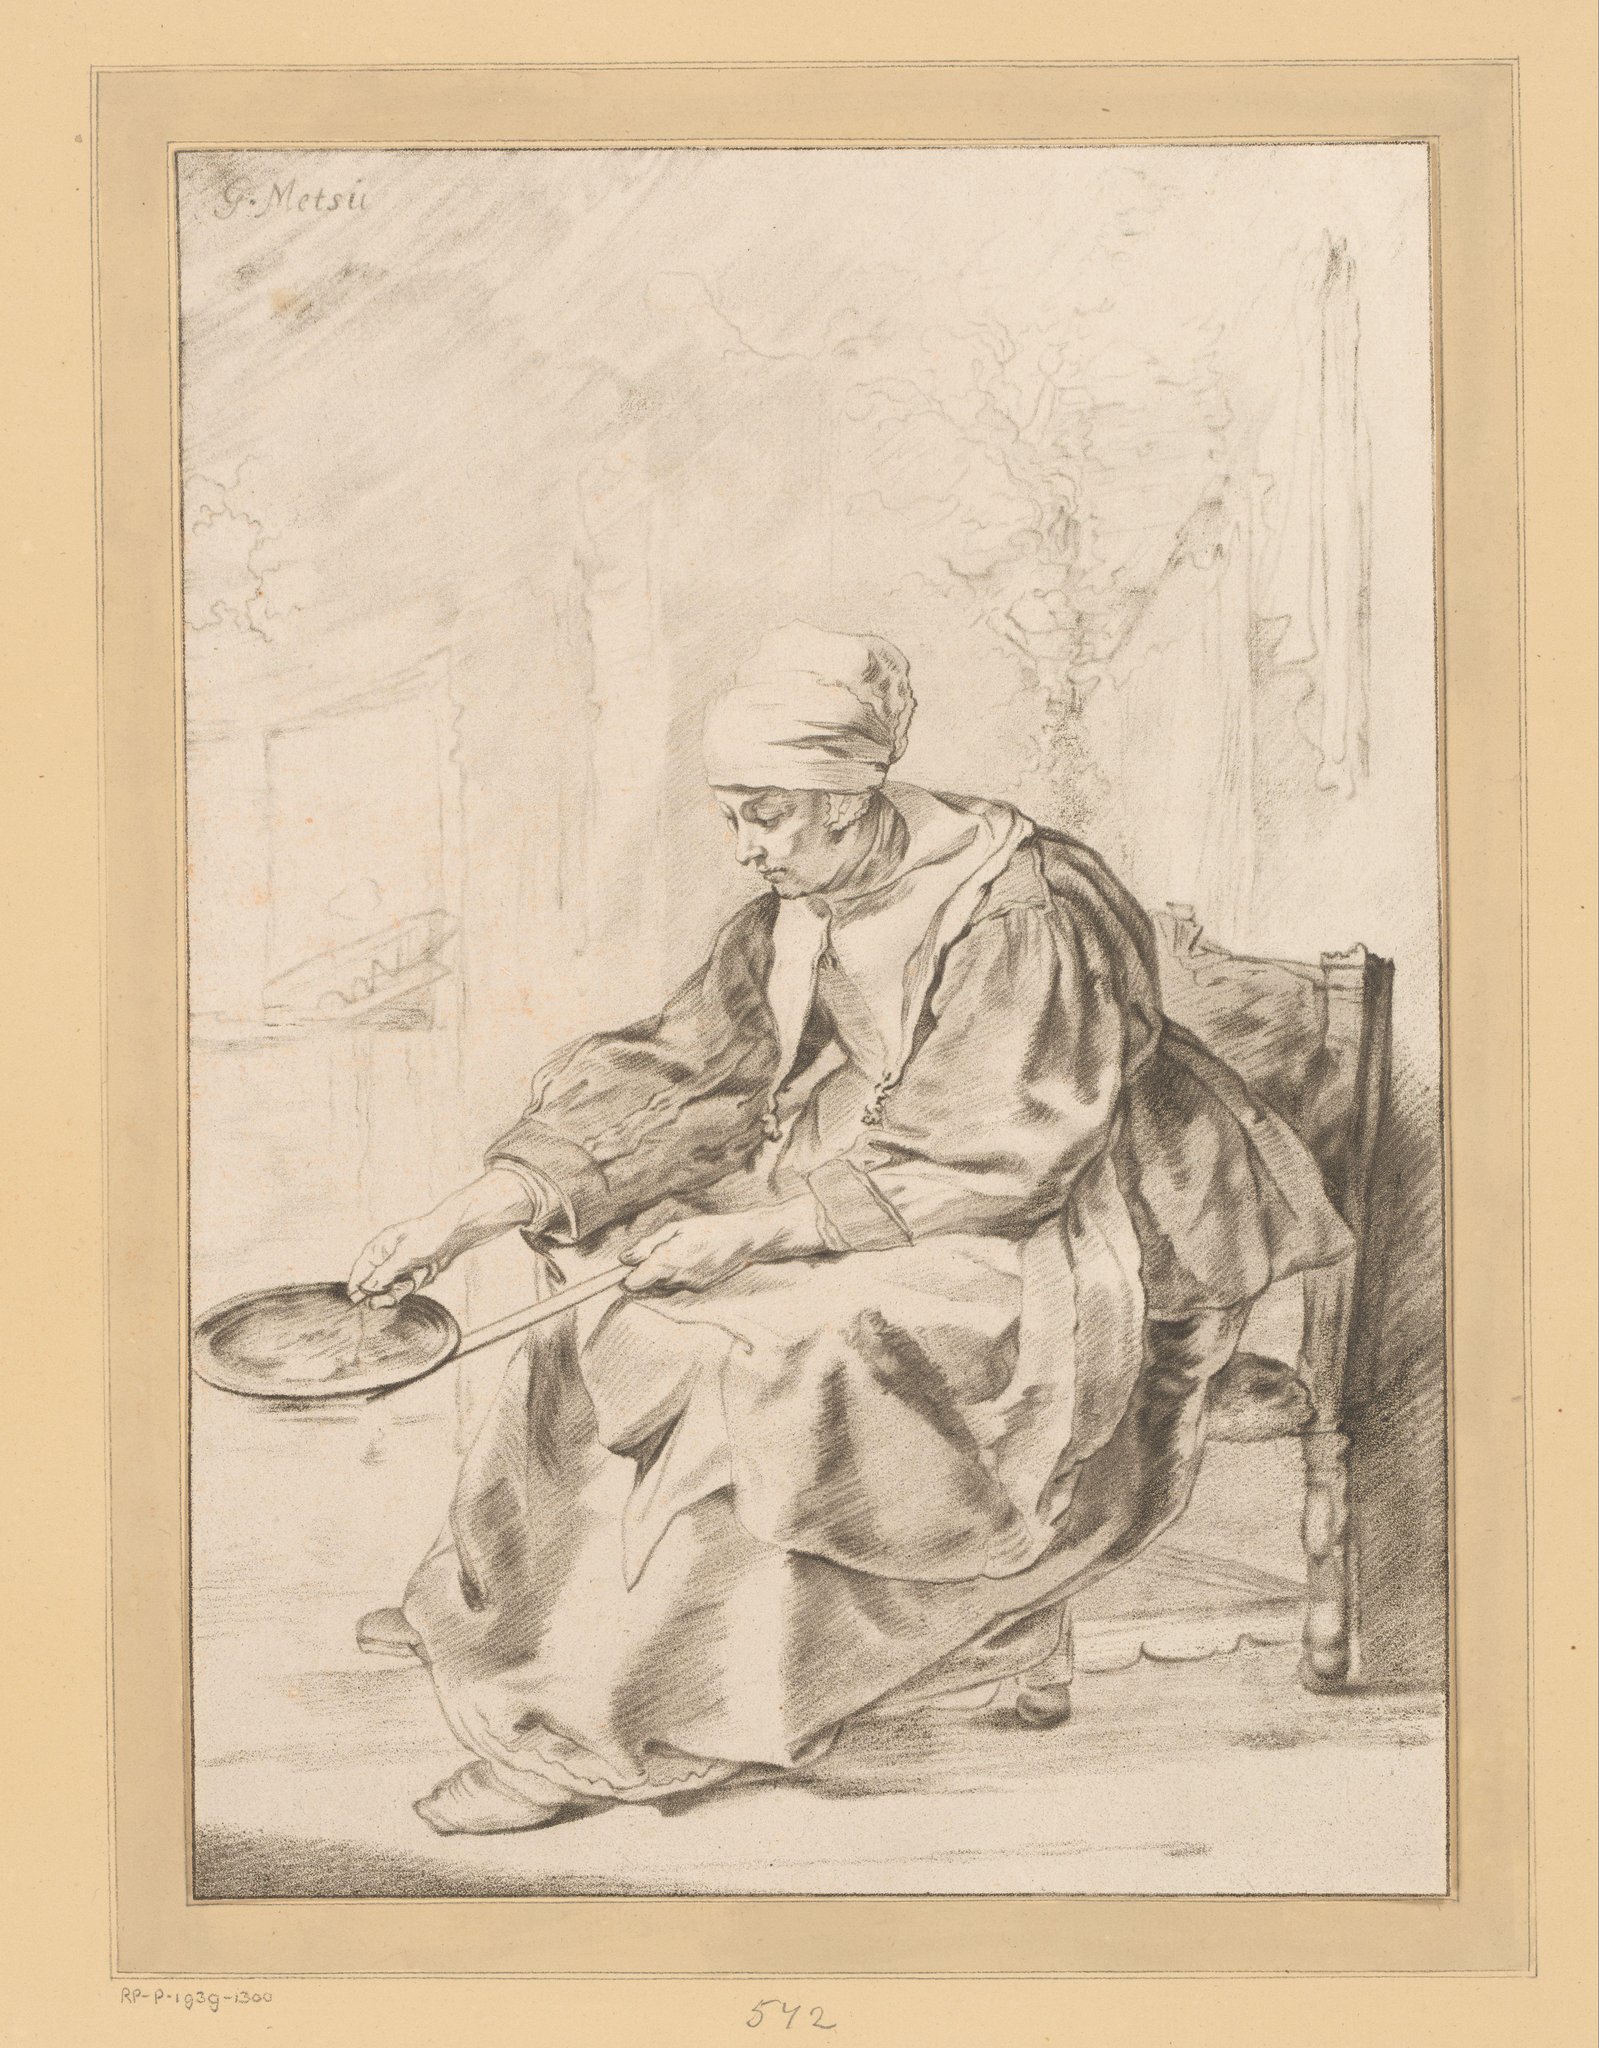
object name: print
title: Pannenkoekenbakster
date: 1768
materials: paper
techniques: printmaking, etching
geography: amsterdam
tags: pancakes, adult woman, cooking food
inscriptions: collector's mark: ‘RIJKS / MUSM’, inscription: ‘G. Metzu del/ CPloos van Amstel F 1768’, collector's mark: Lugt 2725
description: Een vrouw, zittend op een stoel bij een oven, met een koekenpan in haar hand. De prent ligt los in een album, zie blad 14.